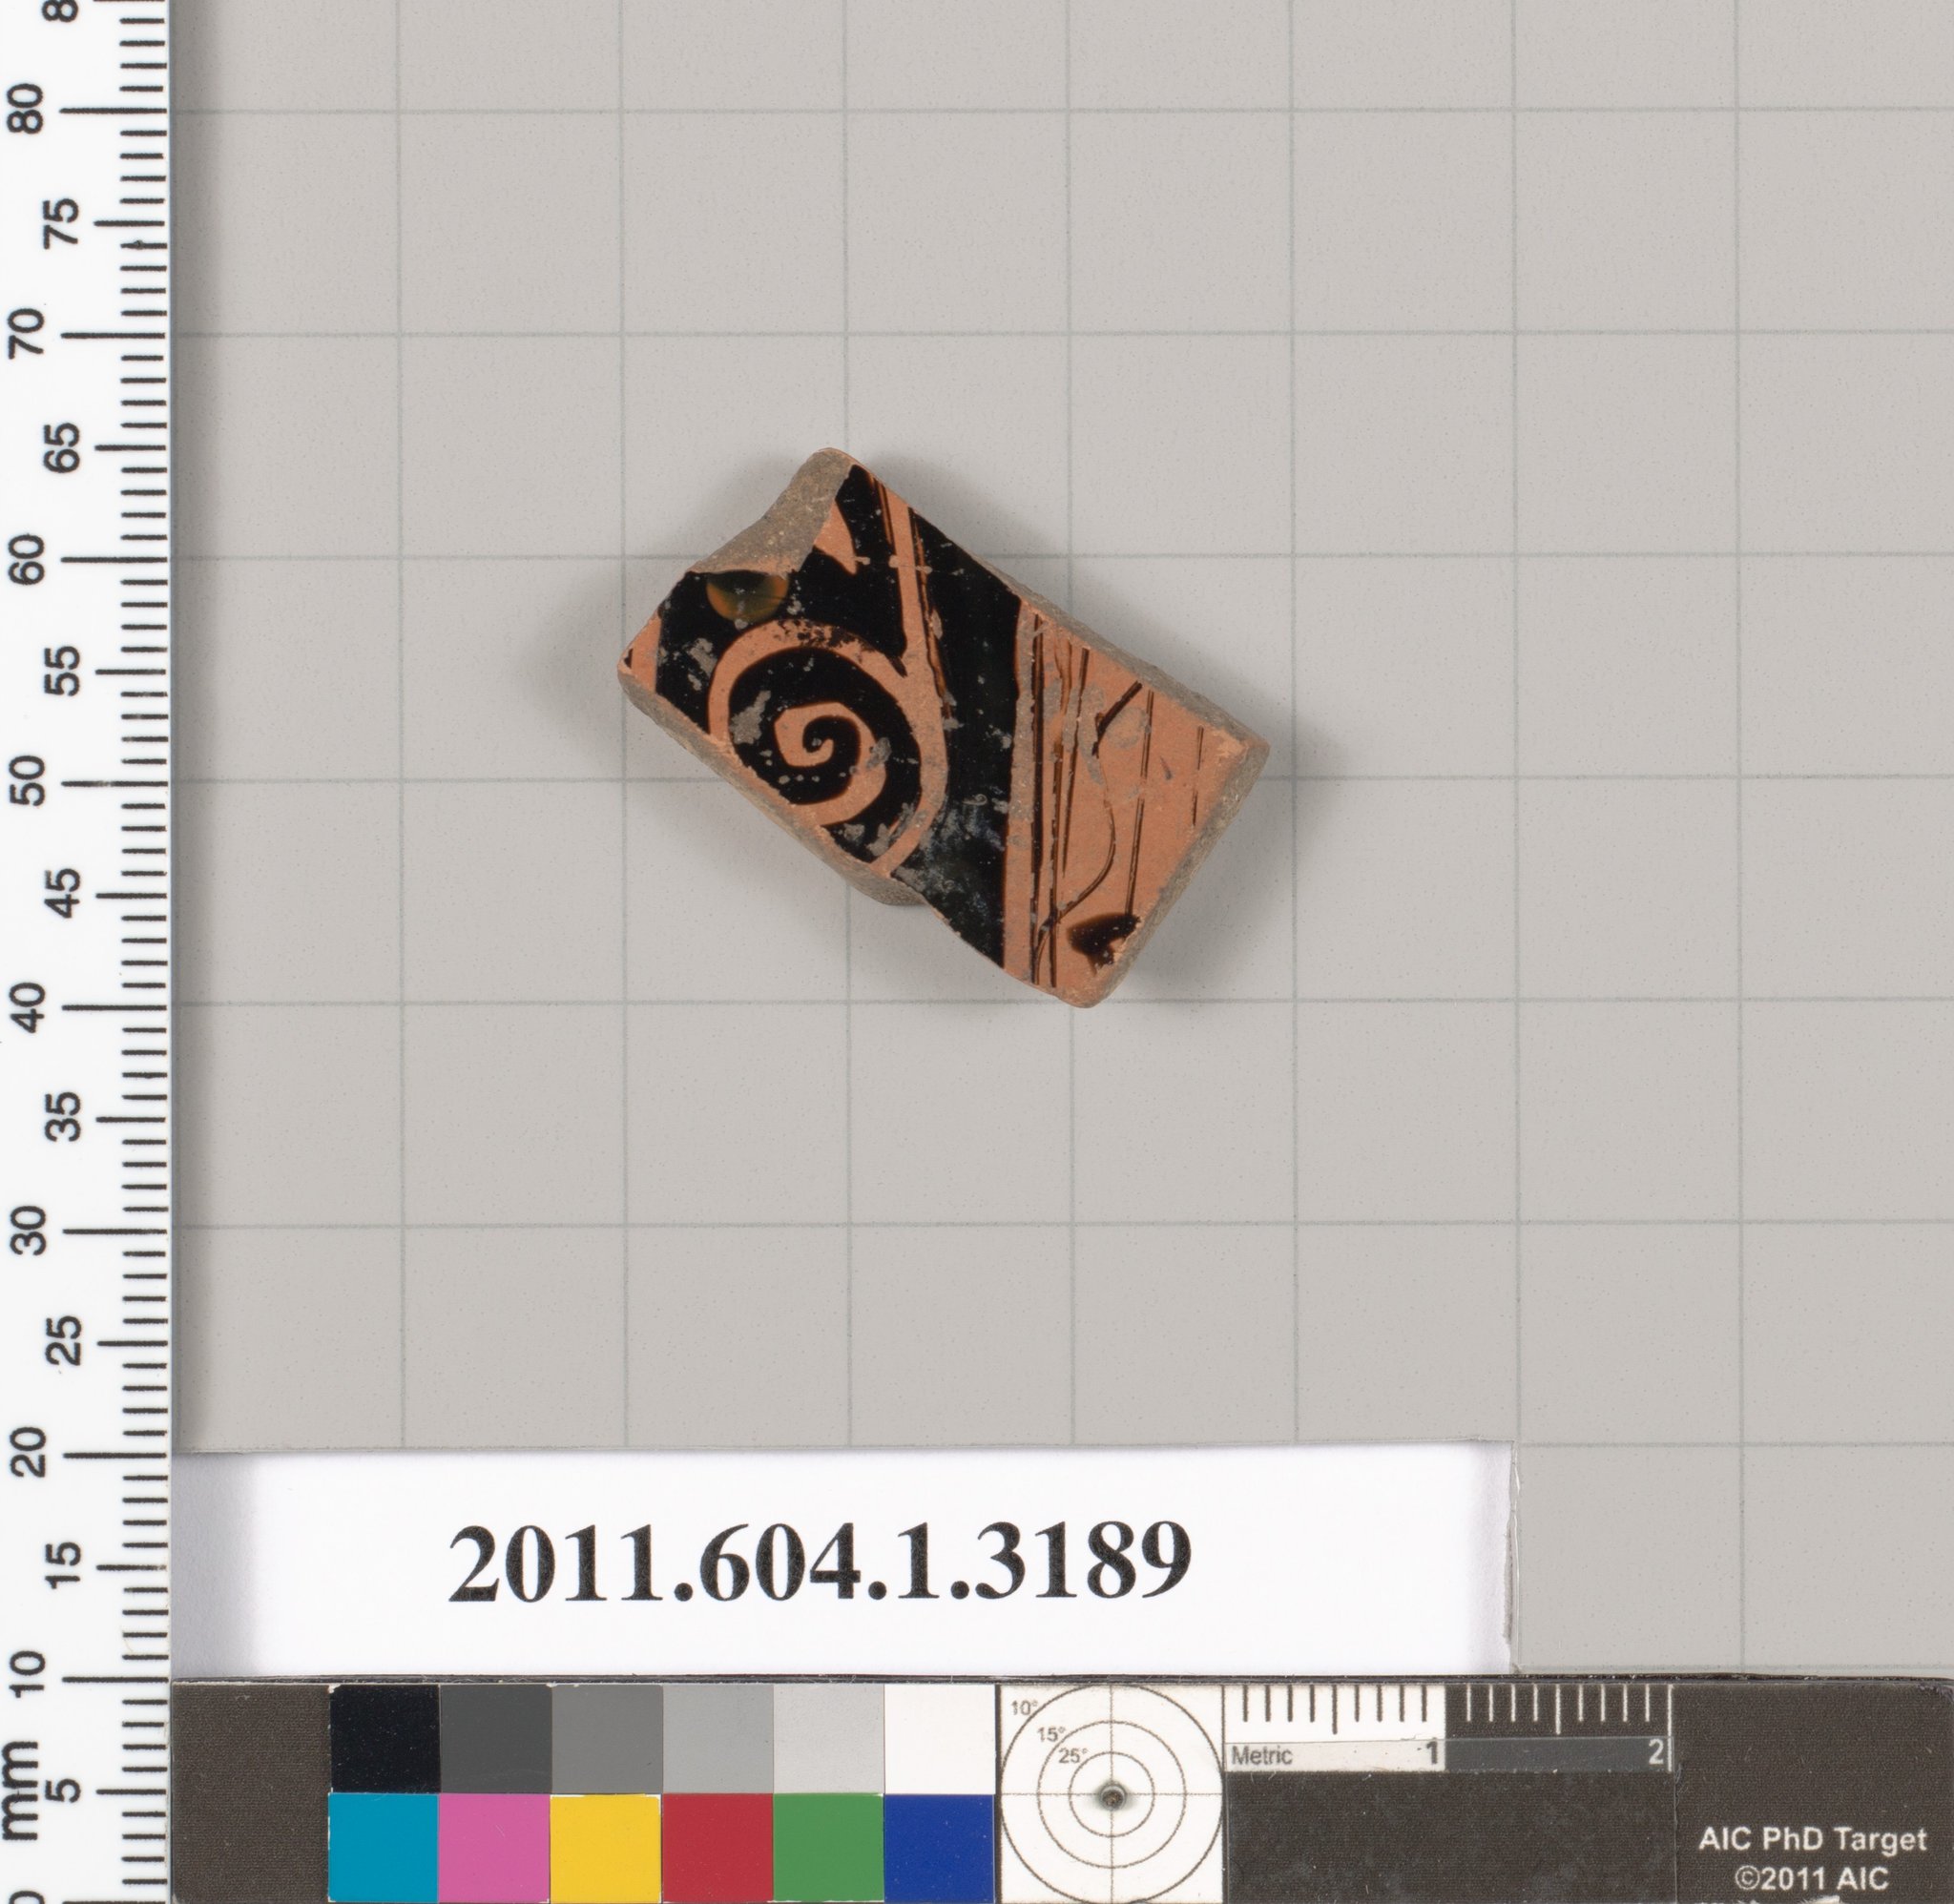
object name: kylix fragment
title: Terracotta fragment of a kylix (drinking cup)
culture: greek, attic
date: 467-435 BCE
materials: terracotta